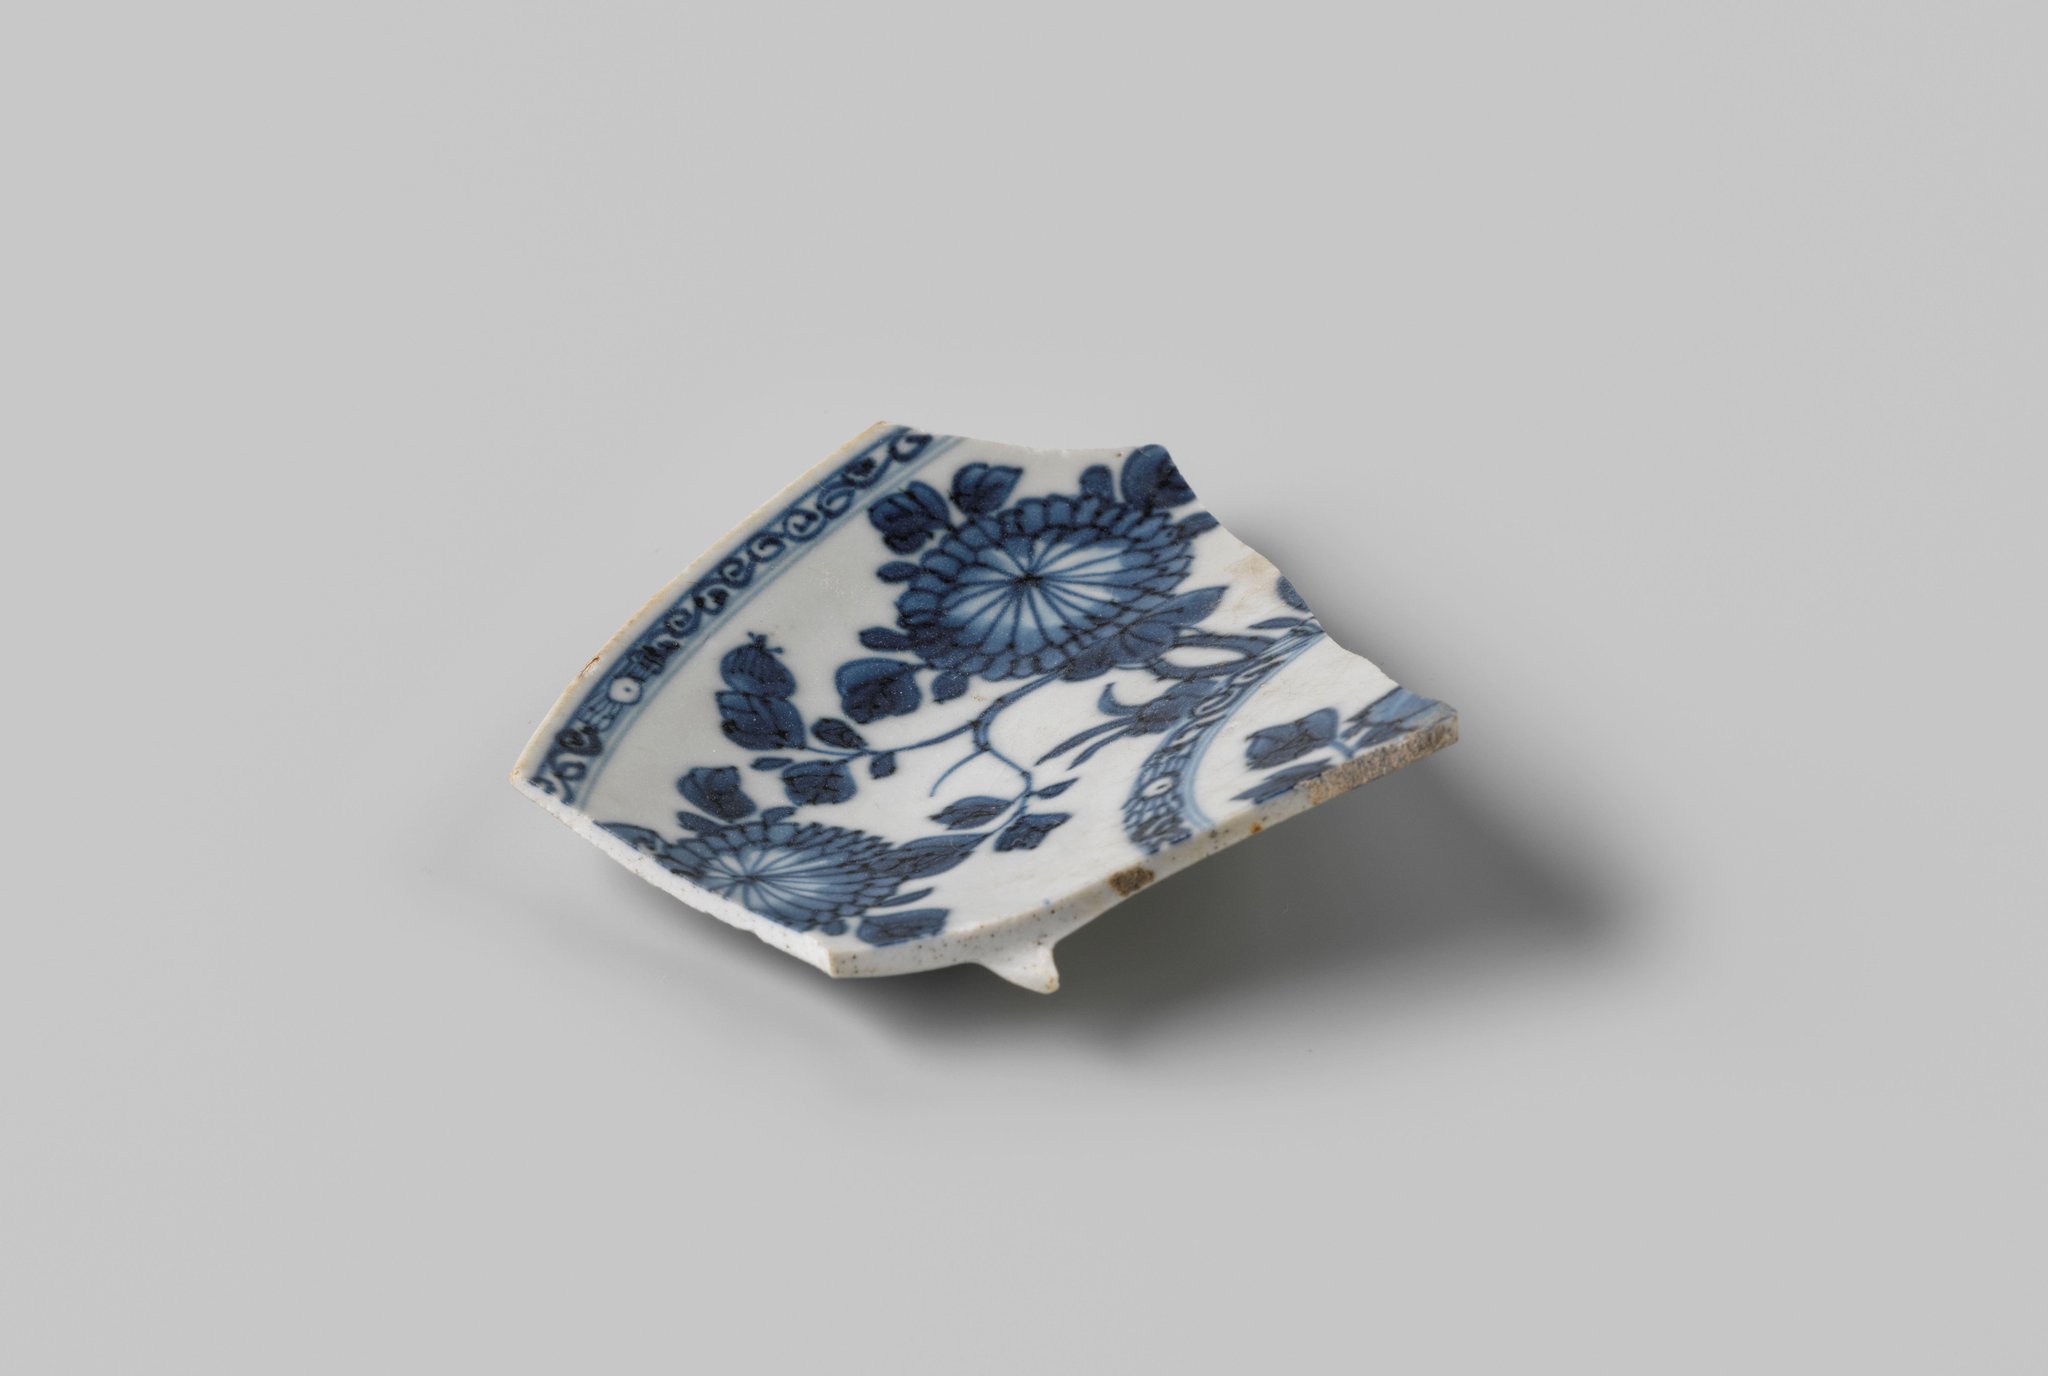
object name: plate dish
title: Bord, gevonden bij V.O.C.-schip Witte Leeuw, mogelijk afkomstig van Zeelelie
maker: Anonymous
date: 1725-1800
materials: porcelain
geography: jingdezhen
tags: verenigde oostindische compagnie, sint-helena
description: Later blue and white Chinese porcelain with flower patterns. Part of a base and cavetto and rim of a plate. A grey white body and grey blue rather accurate painting, under a grey white translucent glaze. Part of the central decoration is visible: a branch with leaves, surrounded by a border of stylized flowers between spirals. On the rim, passing on to the cavetto are large chrysanthemums and leaf scrolls.